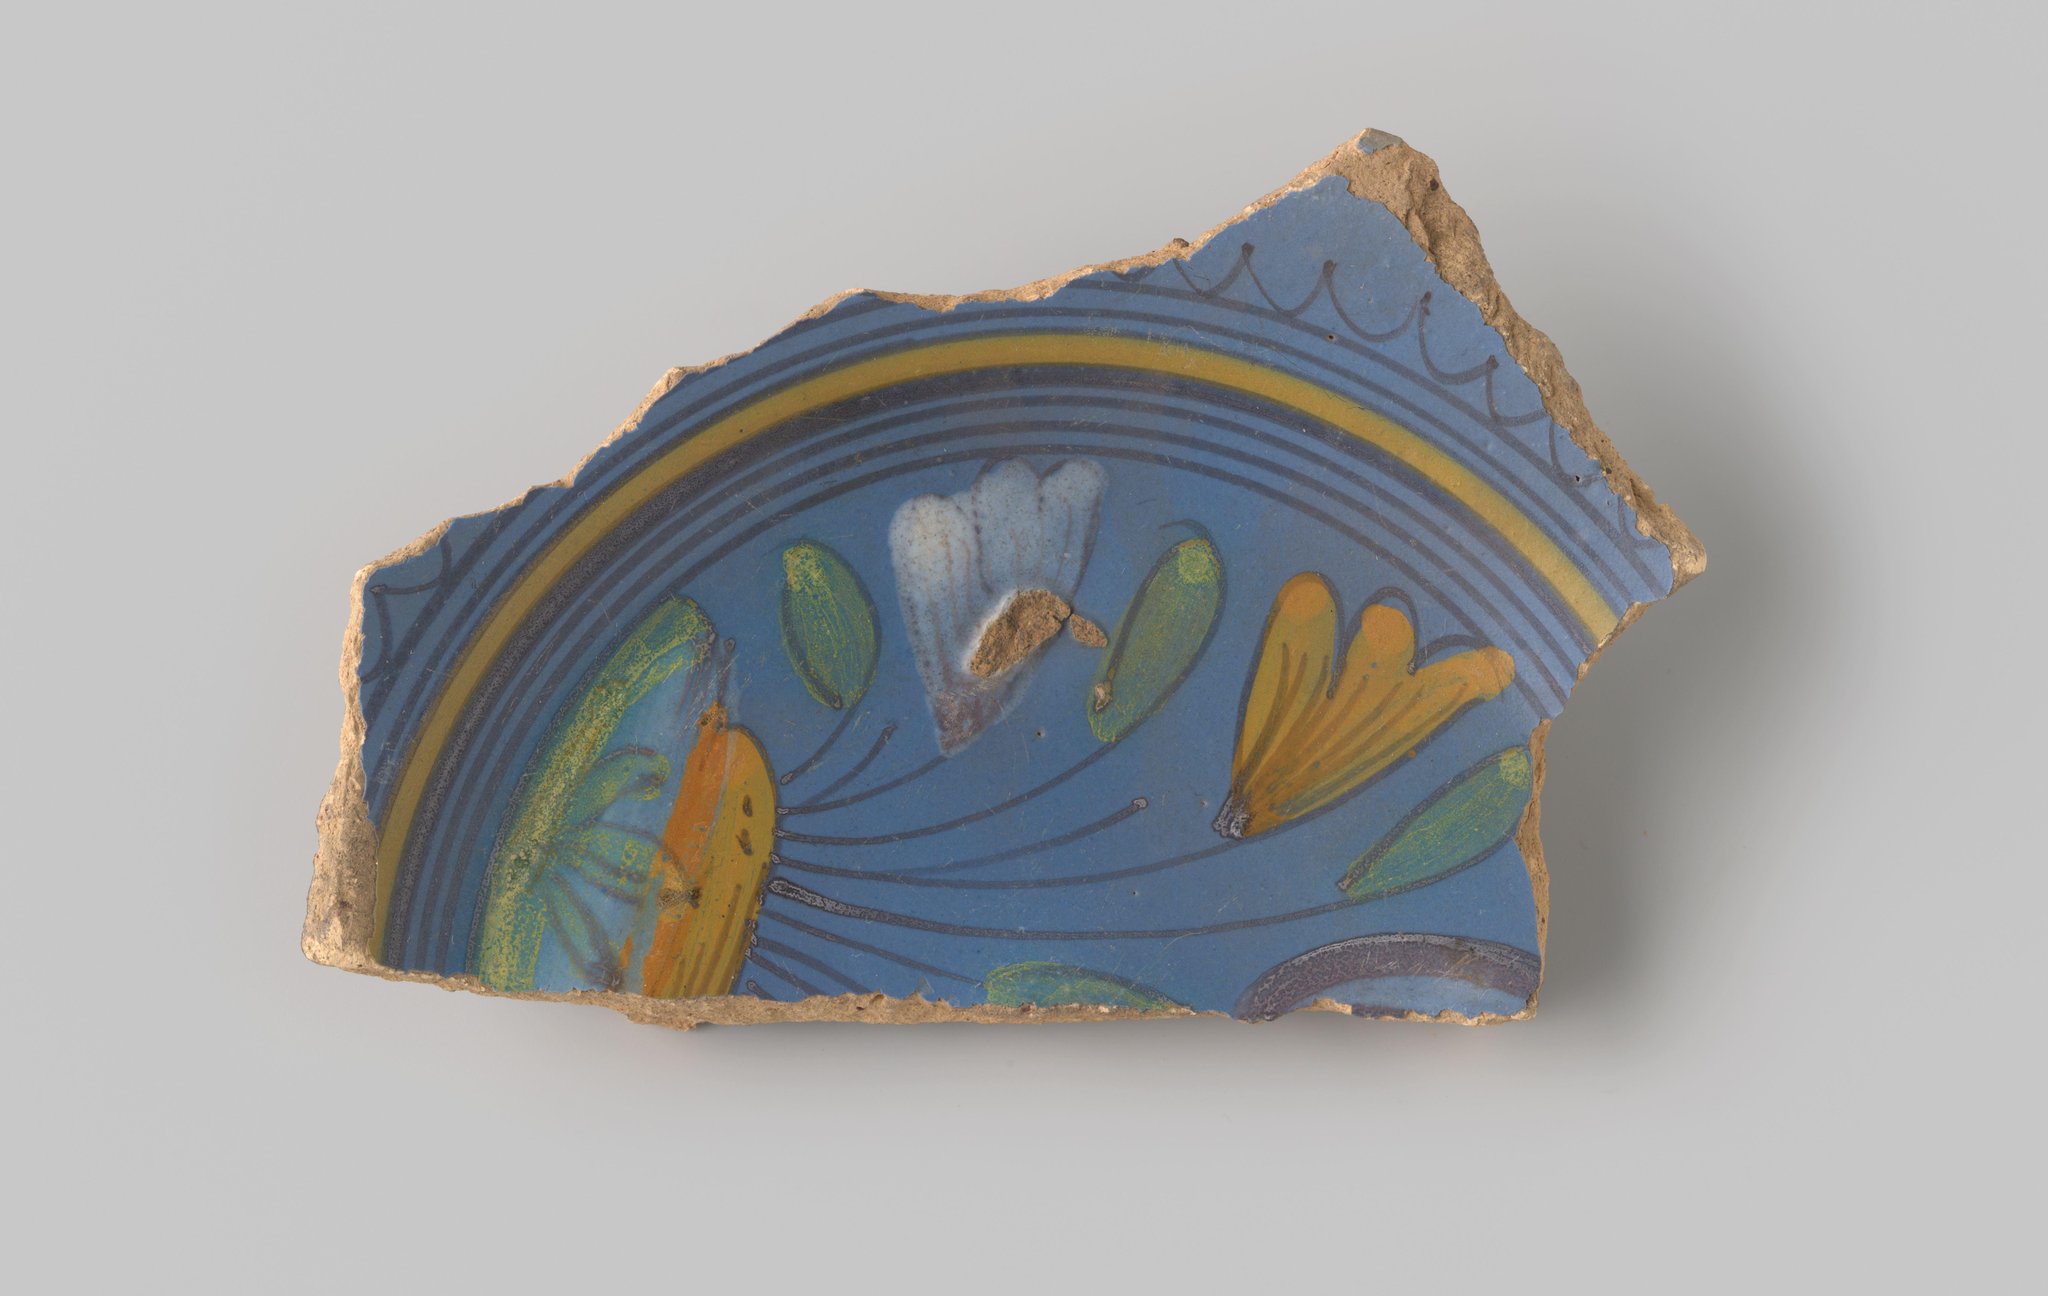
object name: fragment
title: Scherf van rossigbakkend aardewerk, aan de bovenzijde voorzien van blauw glazuur met decoratie van een tafereeltje van bloemen die in de aarde staan in bruin, wit, geel, oranje en groen, en enkele cirkels in bruin en geel eromheen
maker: Anonymous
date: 1600-1650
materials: earthenware, glaze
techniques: maiolica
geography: northern netherlands